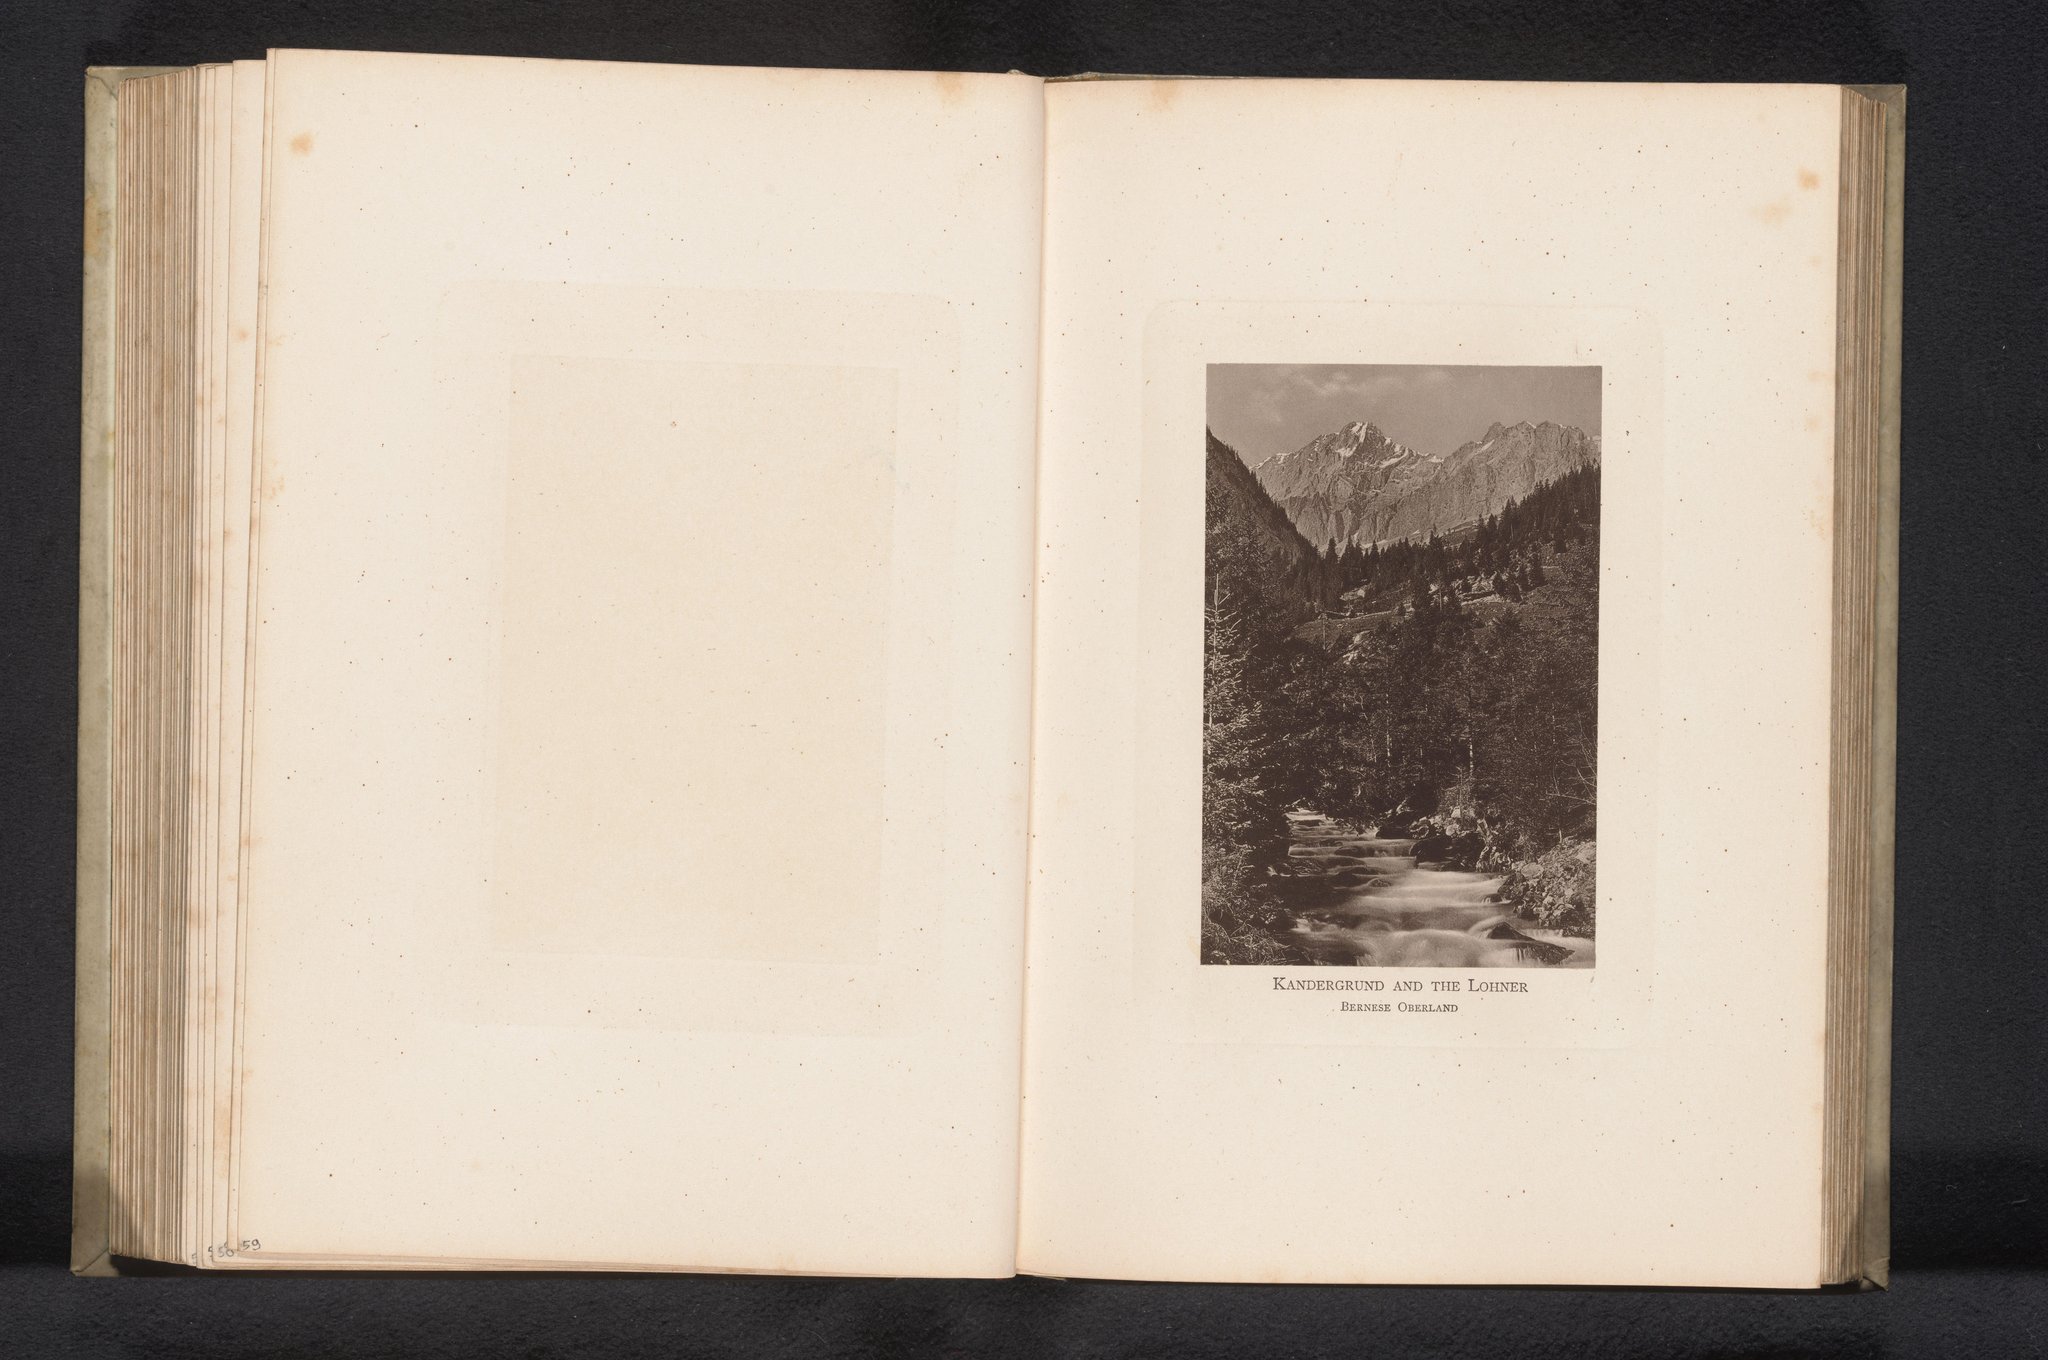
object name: page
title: Gezicht op Kandergrund en de Gross Lohner in het Berner Oberland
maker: Anonymous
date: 1874-1884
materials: paper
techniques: photograph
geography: bern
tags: river, mountains